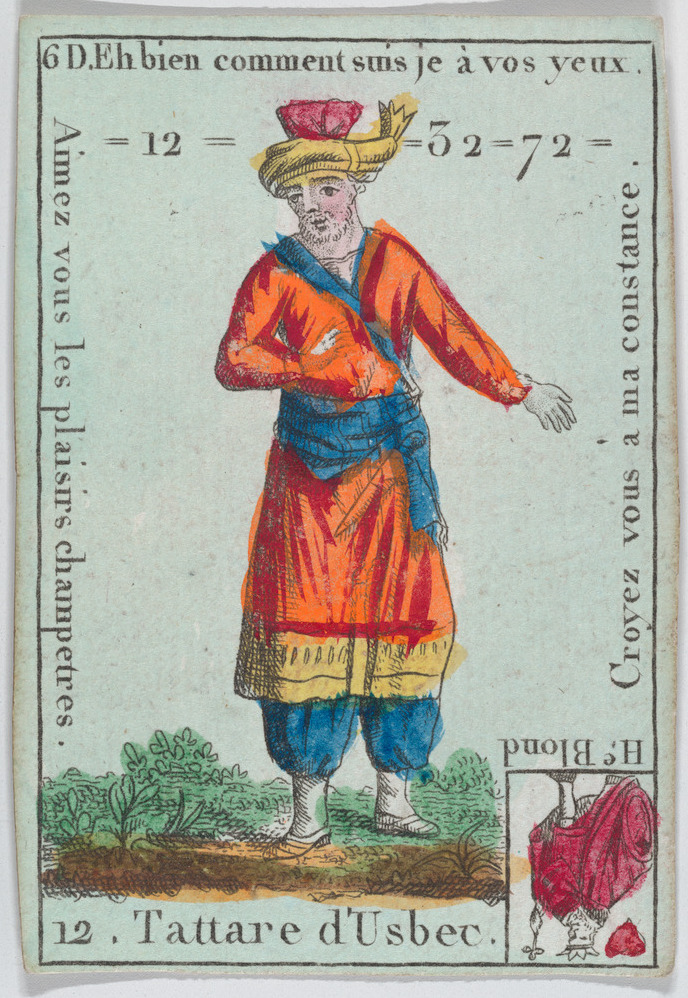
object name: print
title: Tattare d'Usbec from playing cards "Jeu d'Or"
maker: anonymous, french, 18th century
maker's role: artist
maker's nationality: french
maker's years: 1700-1800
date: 1700-1799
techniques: etching, hand coloring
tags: men,portraits,playing cards,mathematics